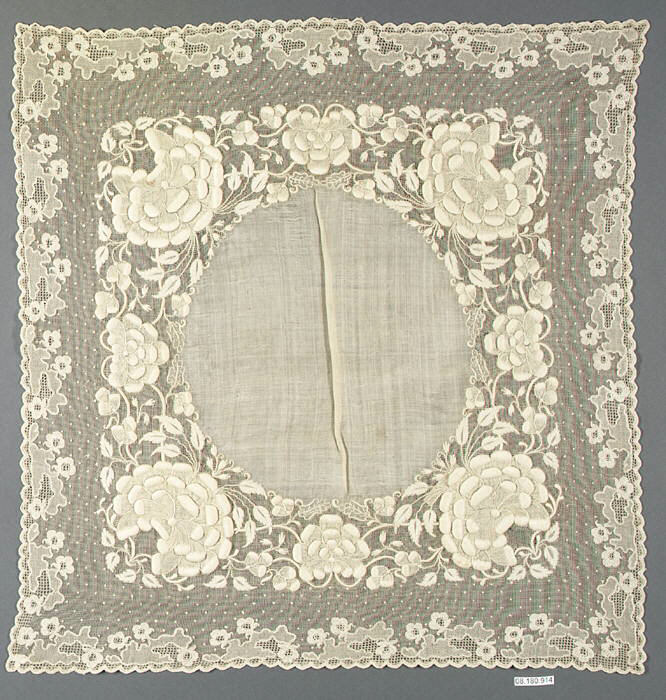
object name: handkerchief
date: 1801-1900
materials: fiber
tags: flowers